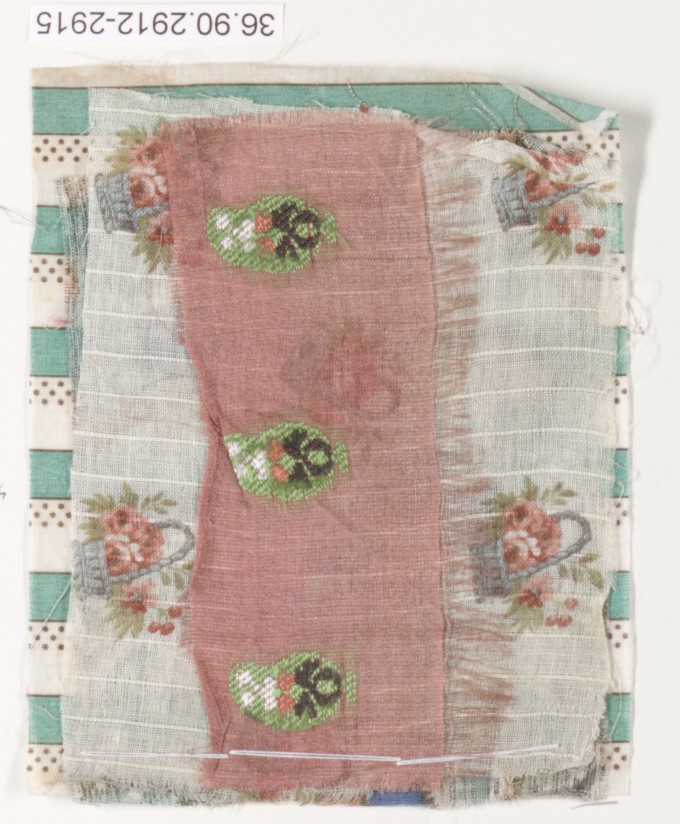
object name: piece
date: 1801-1900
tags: flowers,leaves